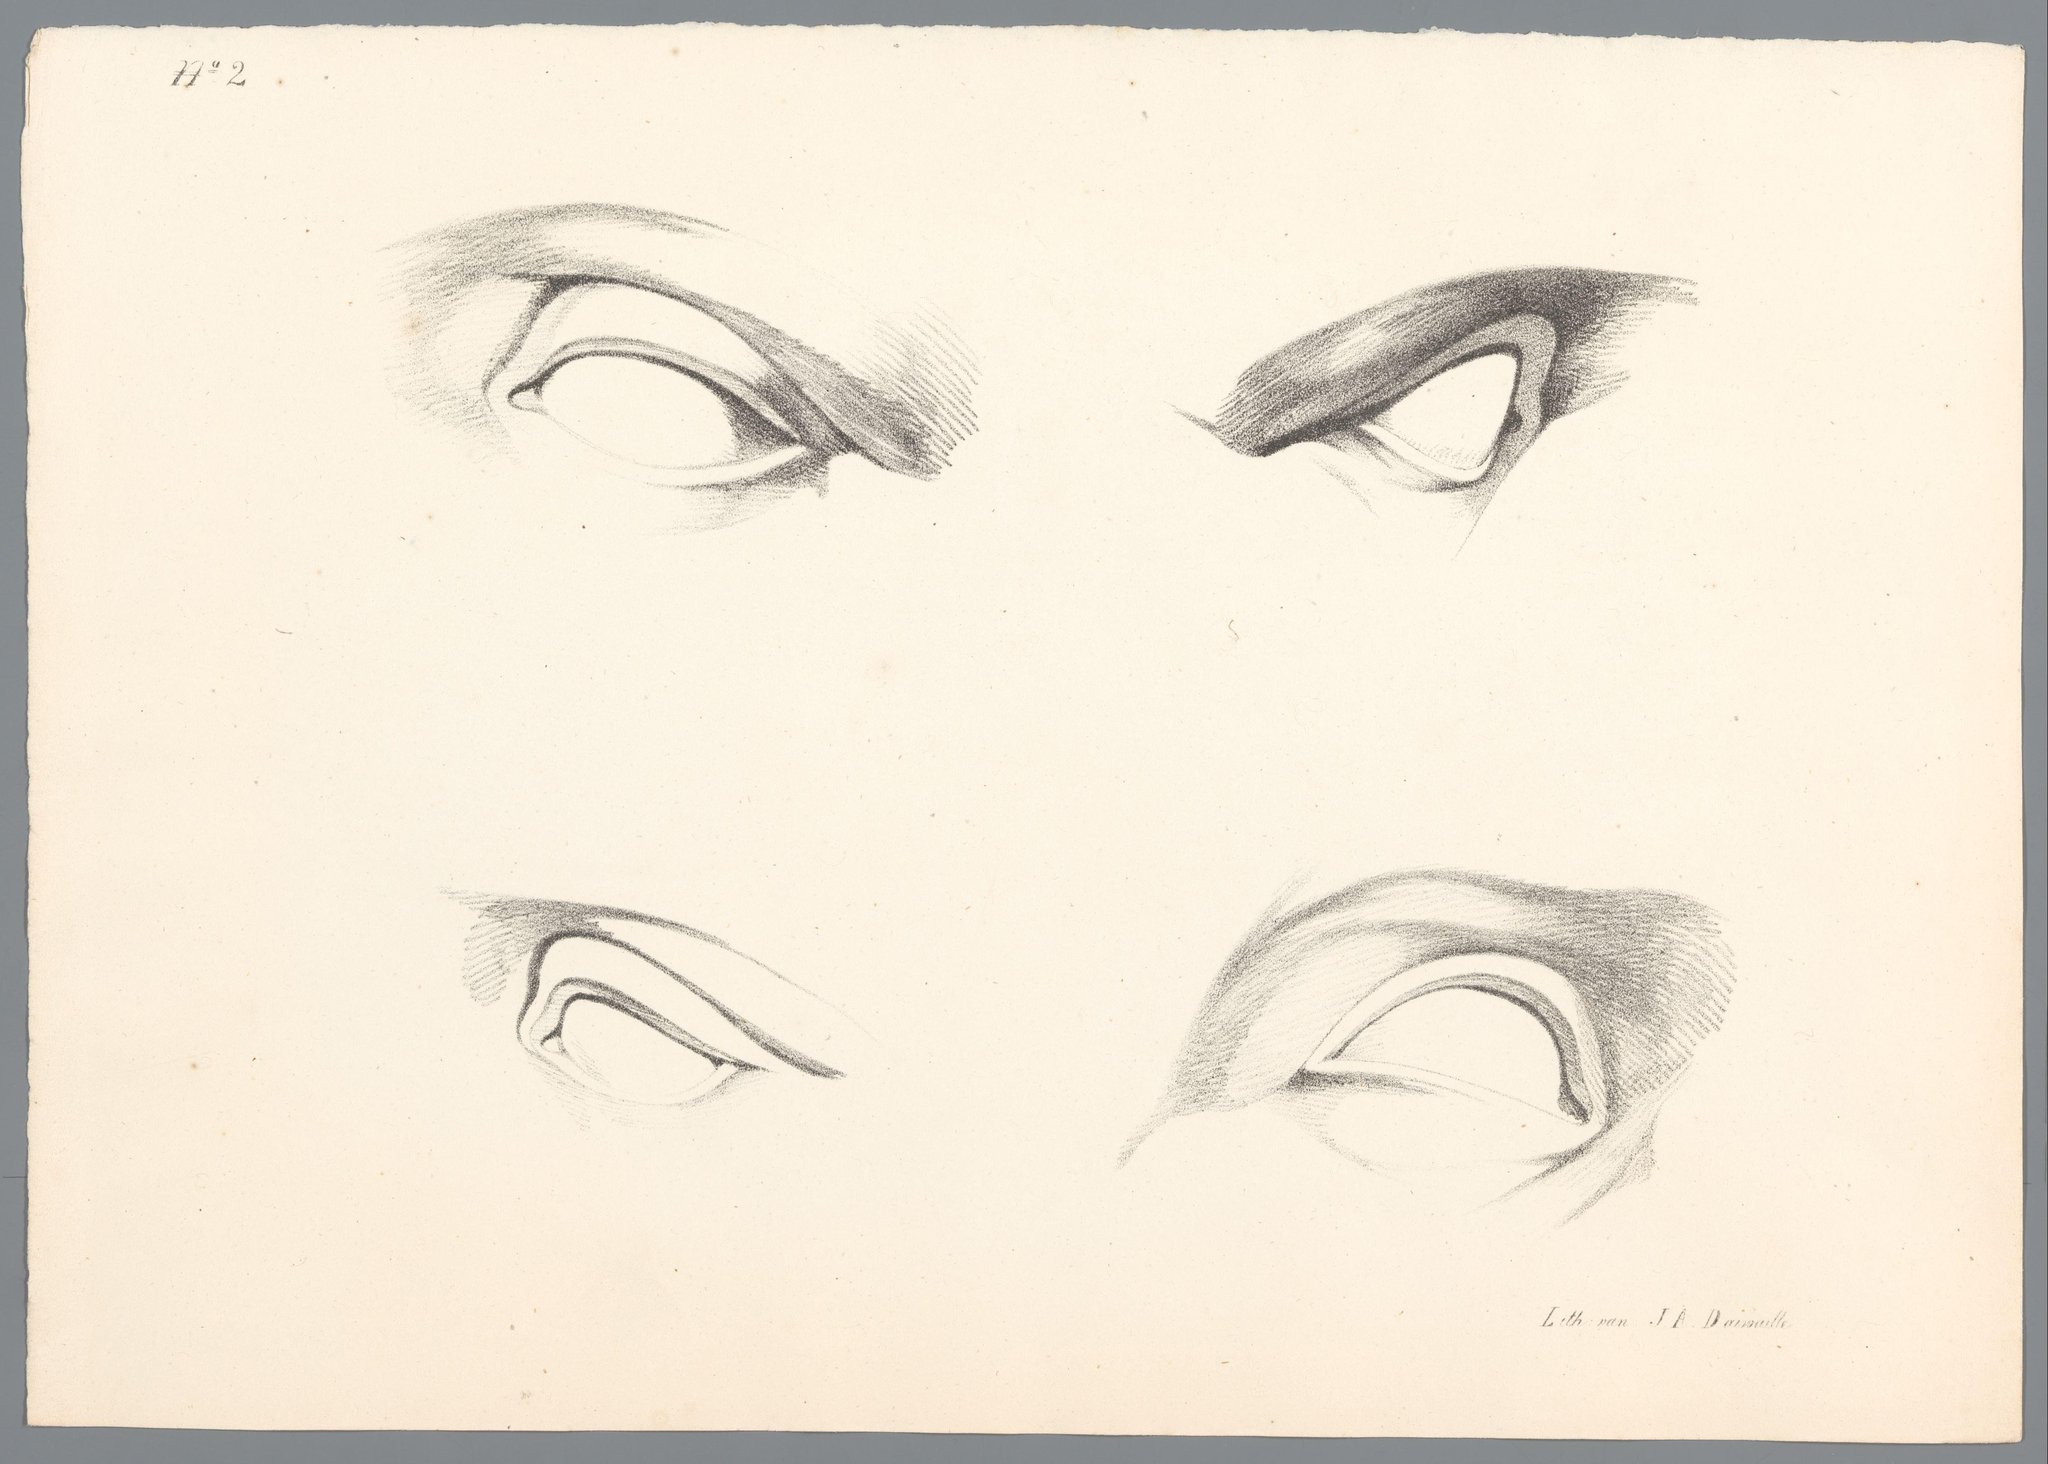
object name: print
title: Vier ogen zonder pupillen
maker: jean augustin daiwaille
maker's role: draughtsman, print maker, printer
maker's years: 1786-1850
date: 1820-1826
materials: paper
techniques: lithograph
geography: amsterdam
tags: eyes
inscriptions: collector's mark: Lugt 2228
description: De ogen hebben geen pupillen of wimpers. Genummerd linksboven: 'No. 2'. Deze prent maakt deel uit van een omslag met veertien prenten.